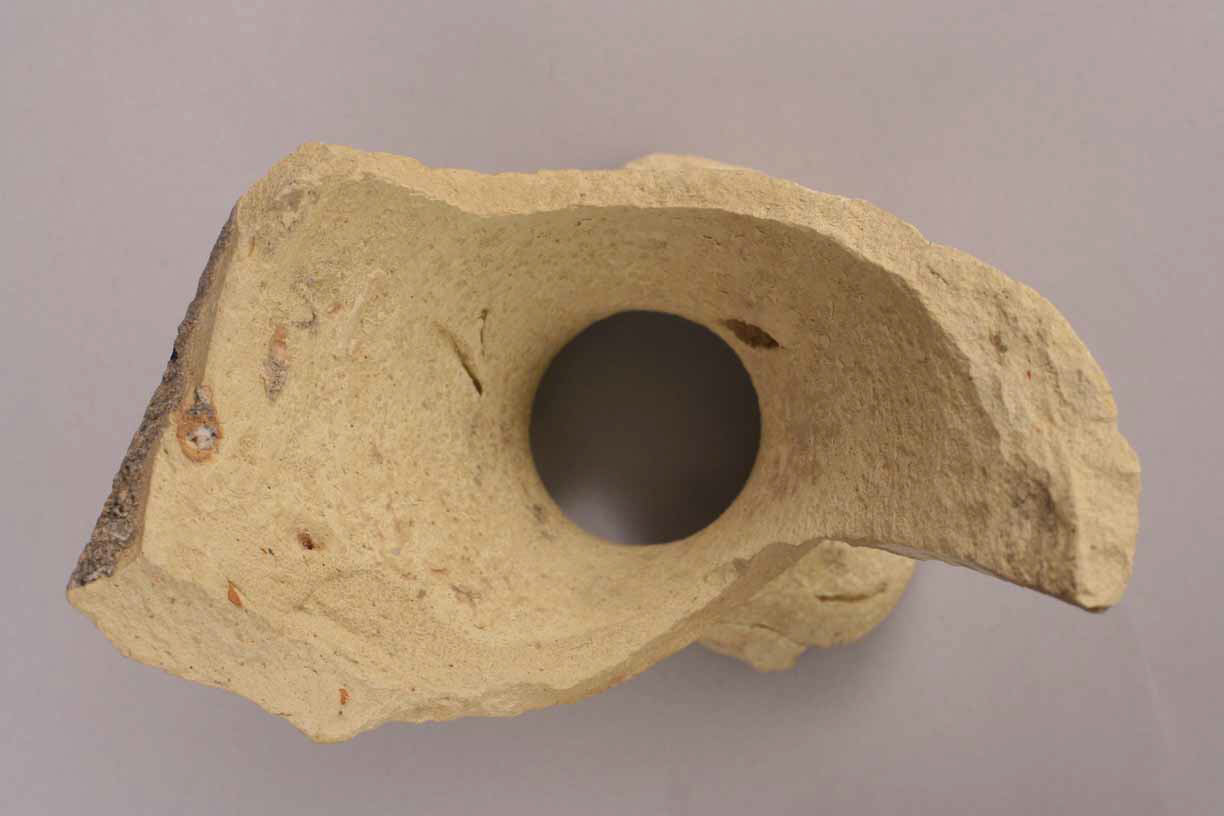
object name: fragment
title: Ceramic Fragment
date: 801-900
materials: earthenware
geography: iraq